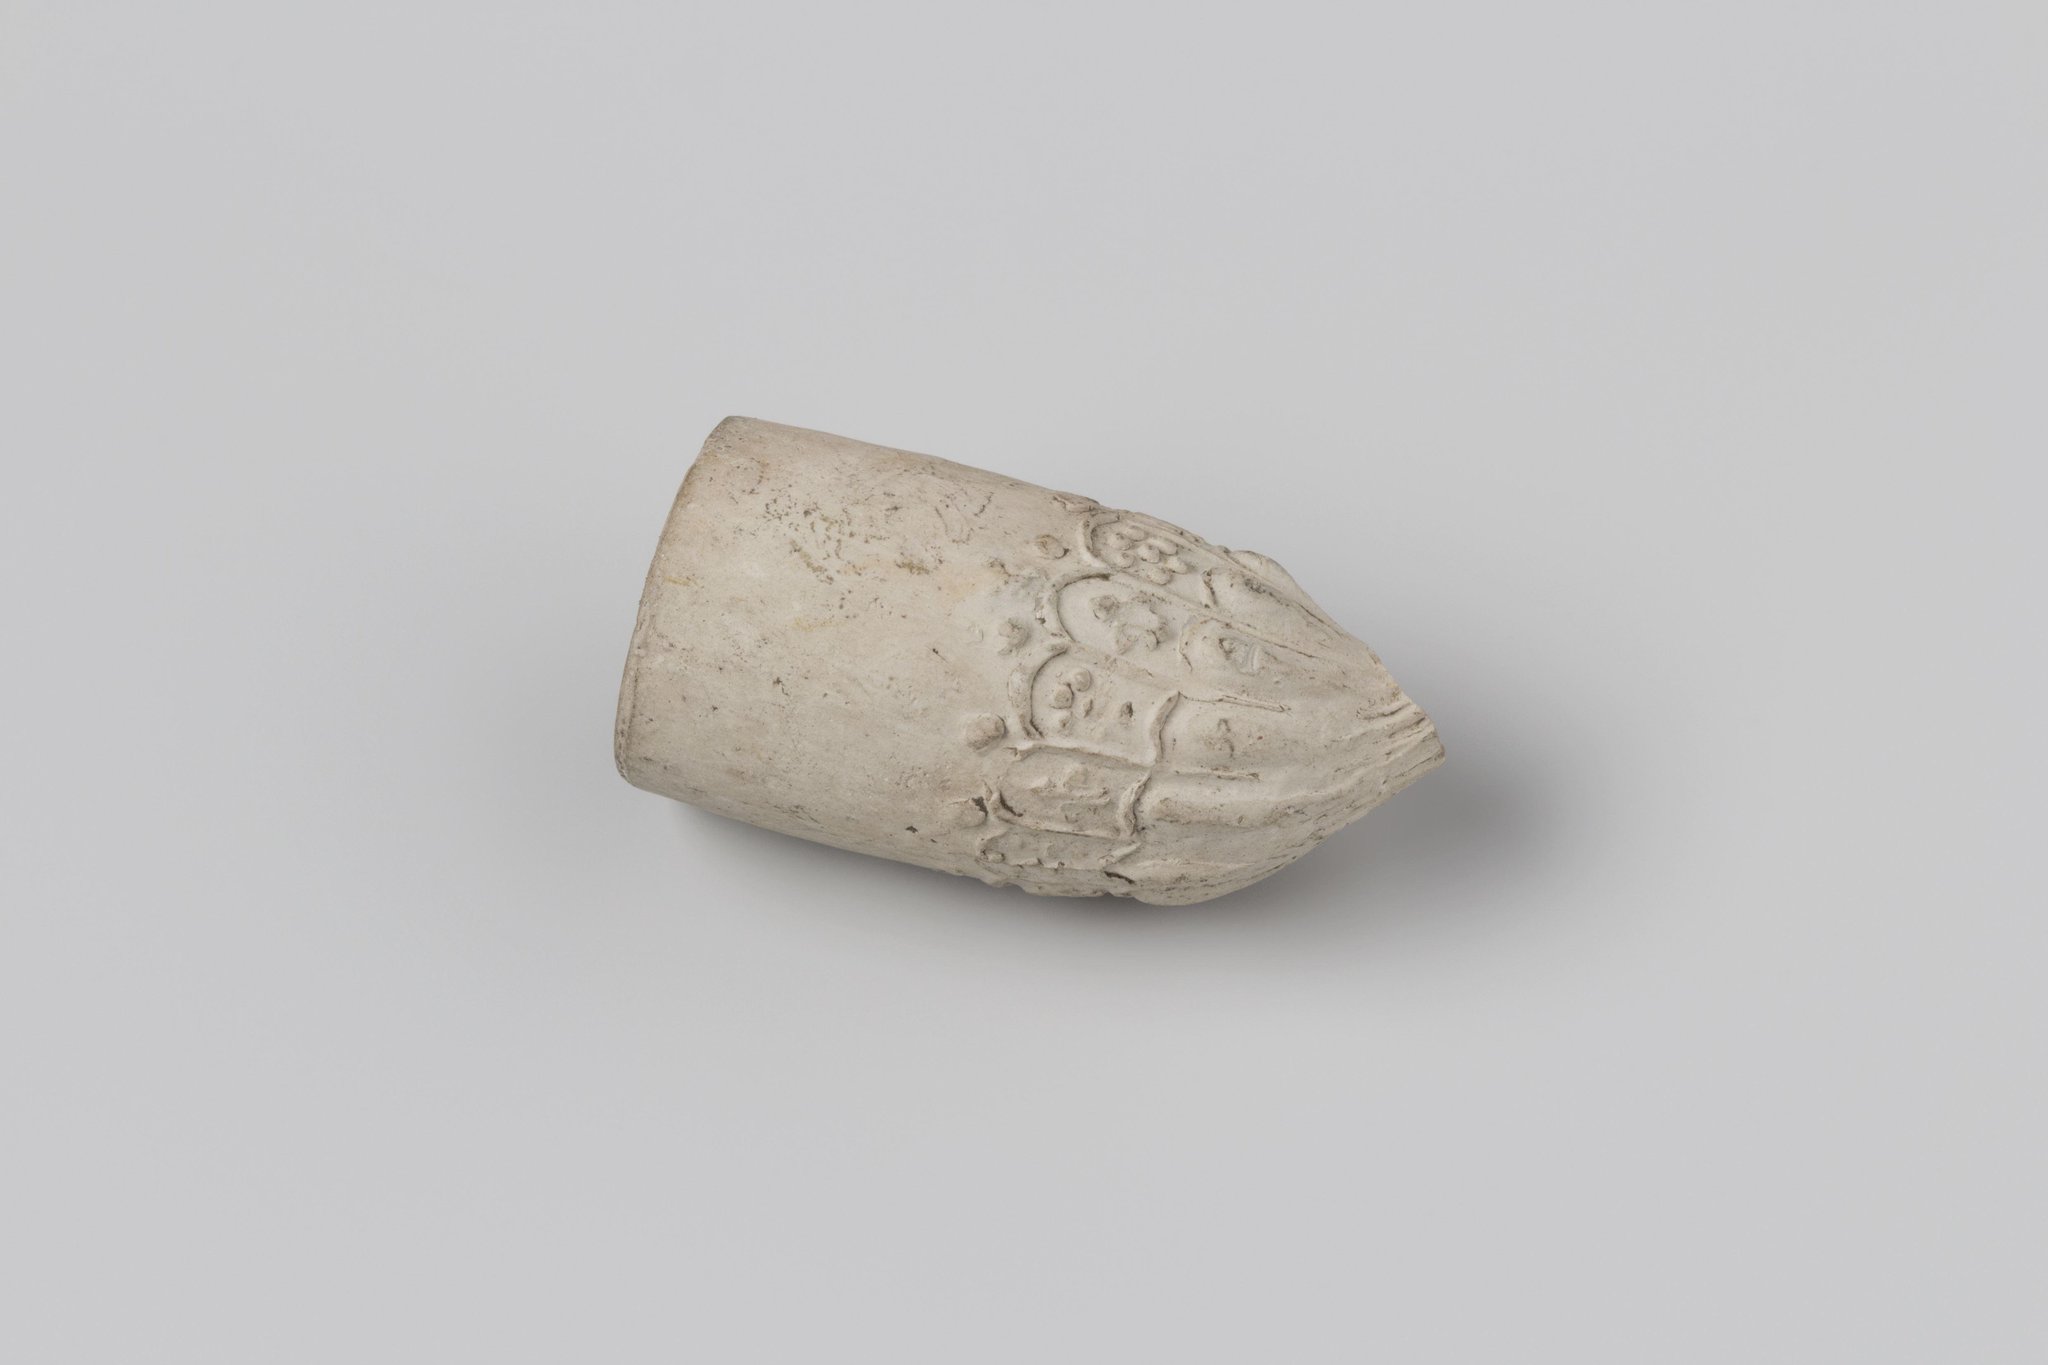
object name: pipe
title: Fragment pijpenkop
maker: jan nieuwveld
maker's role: pijpenfabrikant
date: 1740-1780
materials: clay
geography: gouda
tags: the hague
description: Fragment pijpenkop, rondbodem model, met knorren in omlijning (floraal uitwaaiend motief), aan de bovenzijde eindigend in boogjes waarin afwisselend gestileerde roosjes en lelies en boven de boogjes een rij bloemen. Van de opgravingen op de Hofstede Arentsburg 1827-1831 onder toezicht van Professor Reuvens.